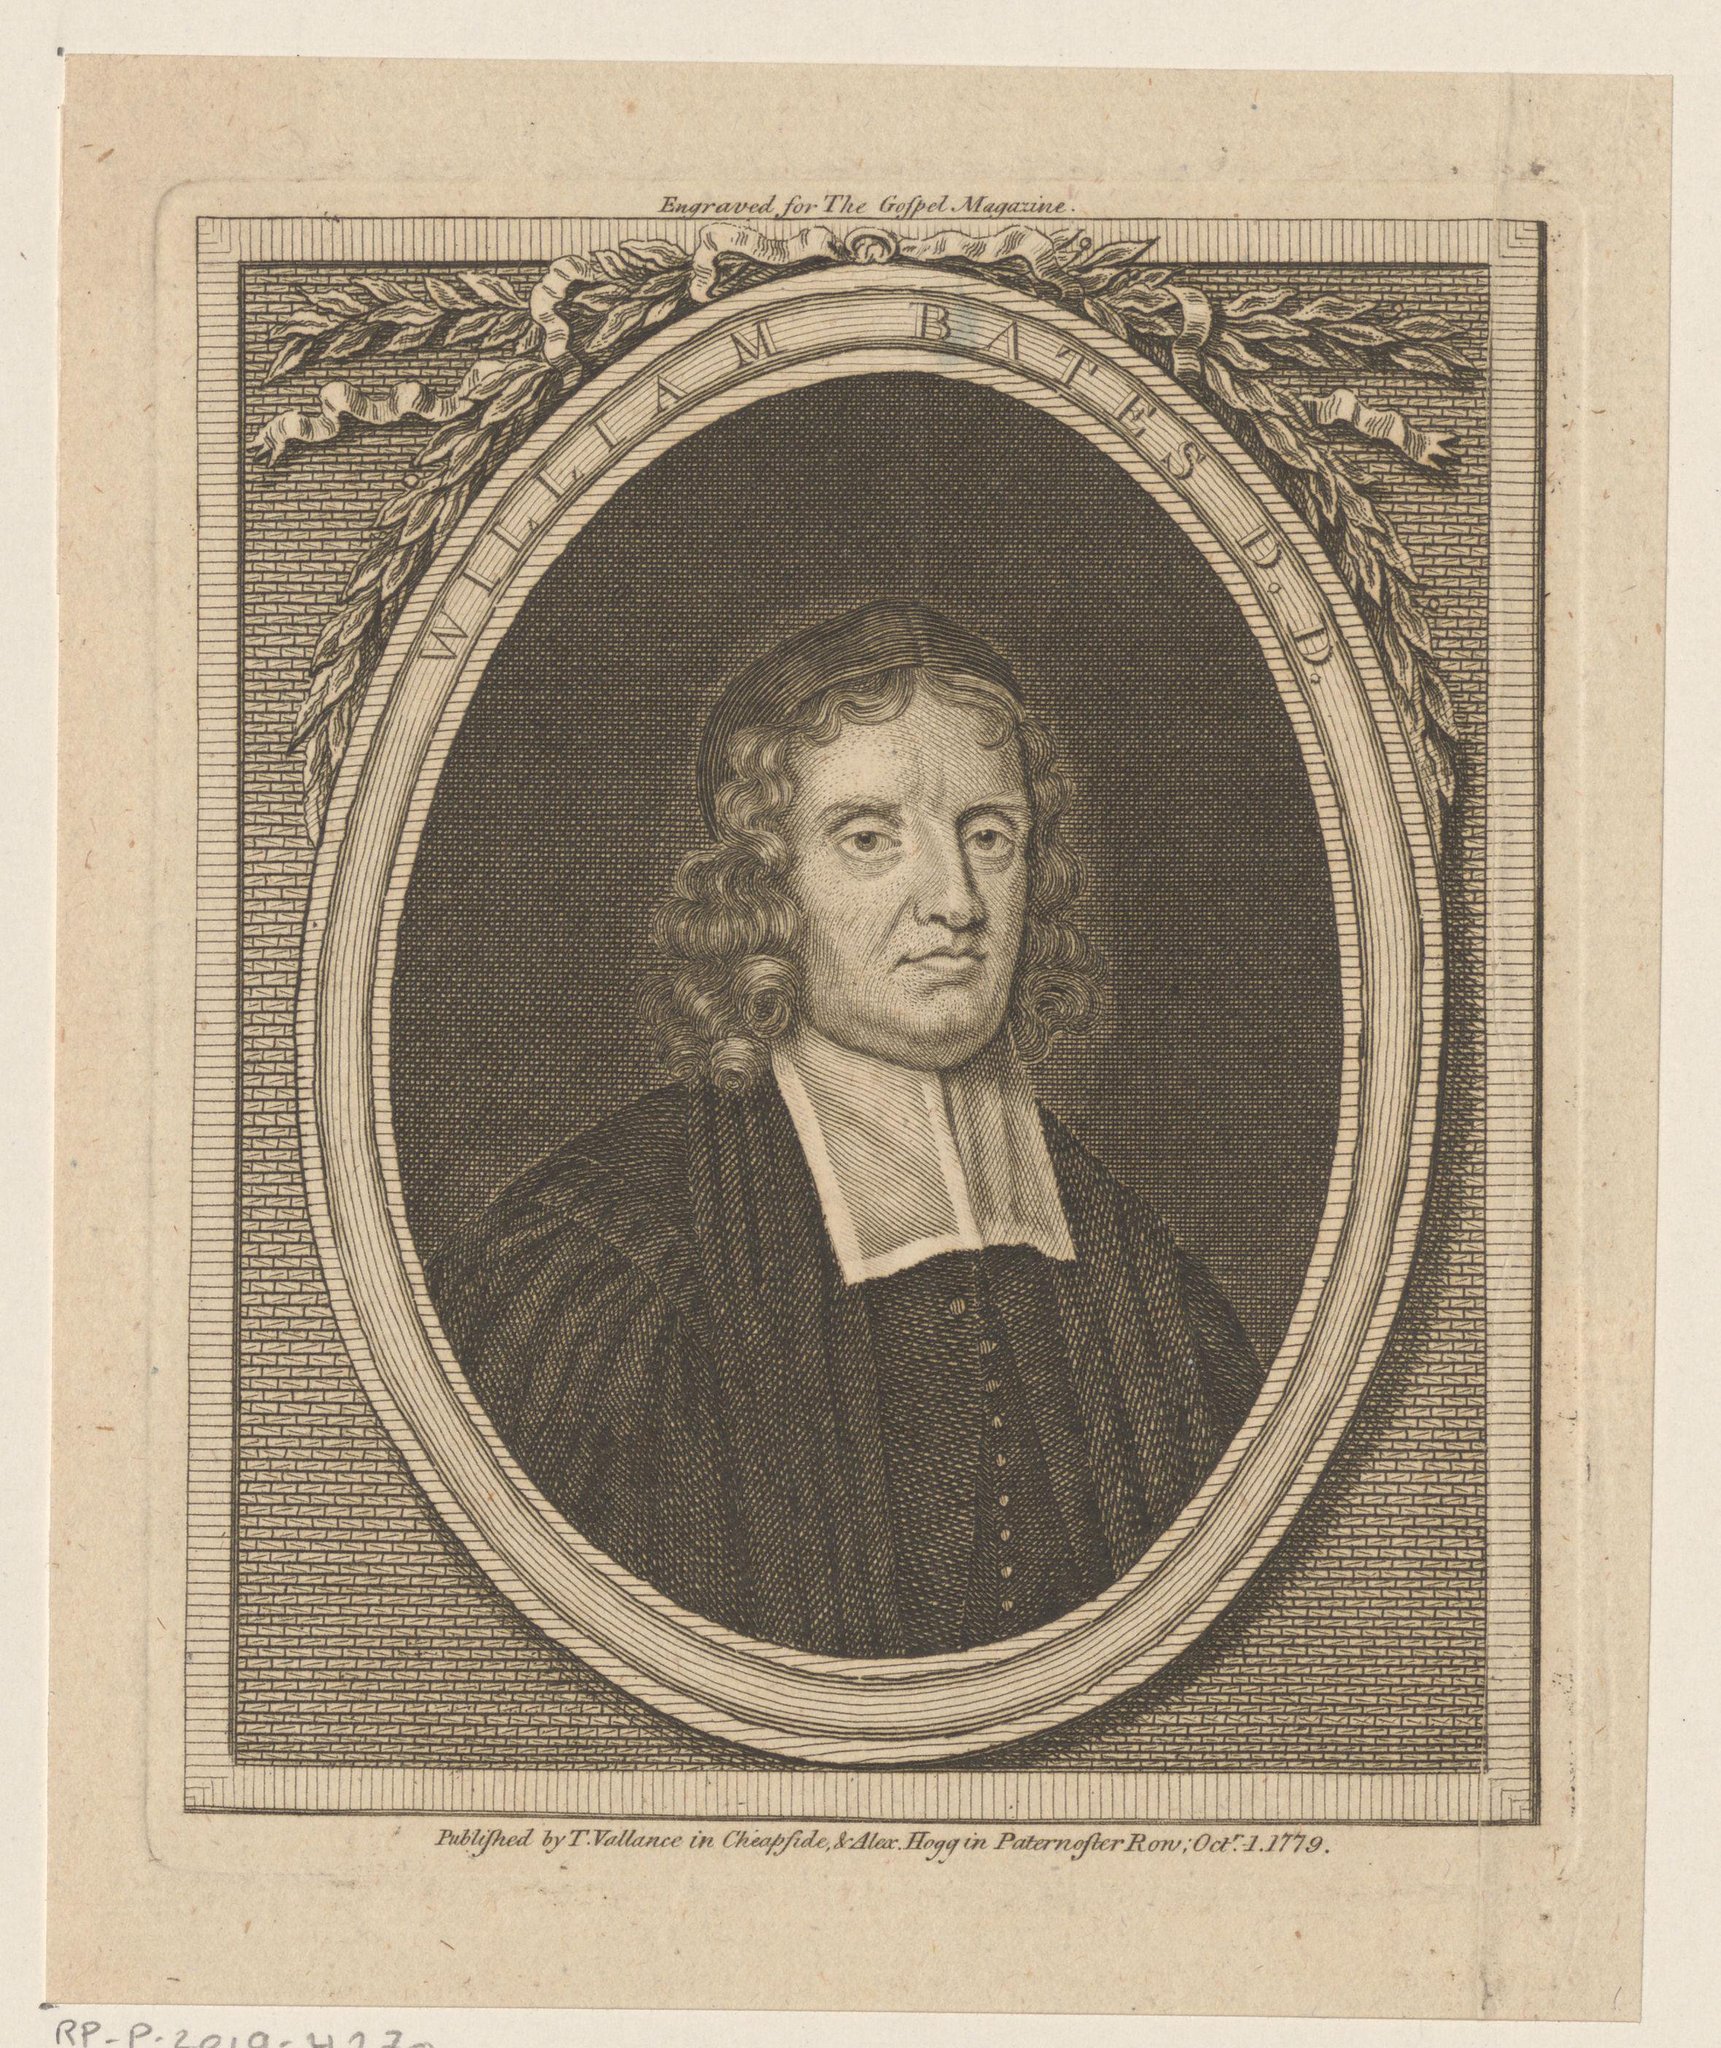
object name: print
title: Portret van William Bates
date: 1779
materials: paper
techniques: engraving, etching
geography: london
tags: london, clergyman, historical persons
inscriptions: date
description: Prent uit: The Gospel Magazine, september 1779.